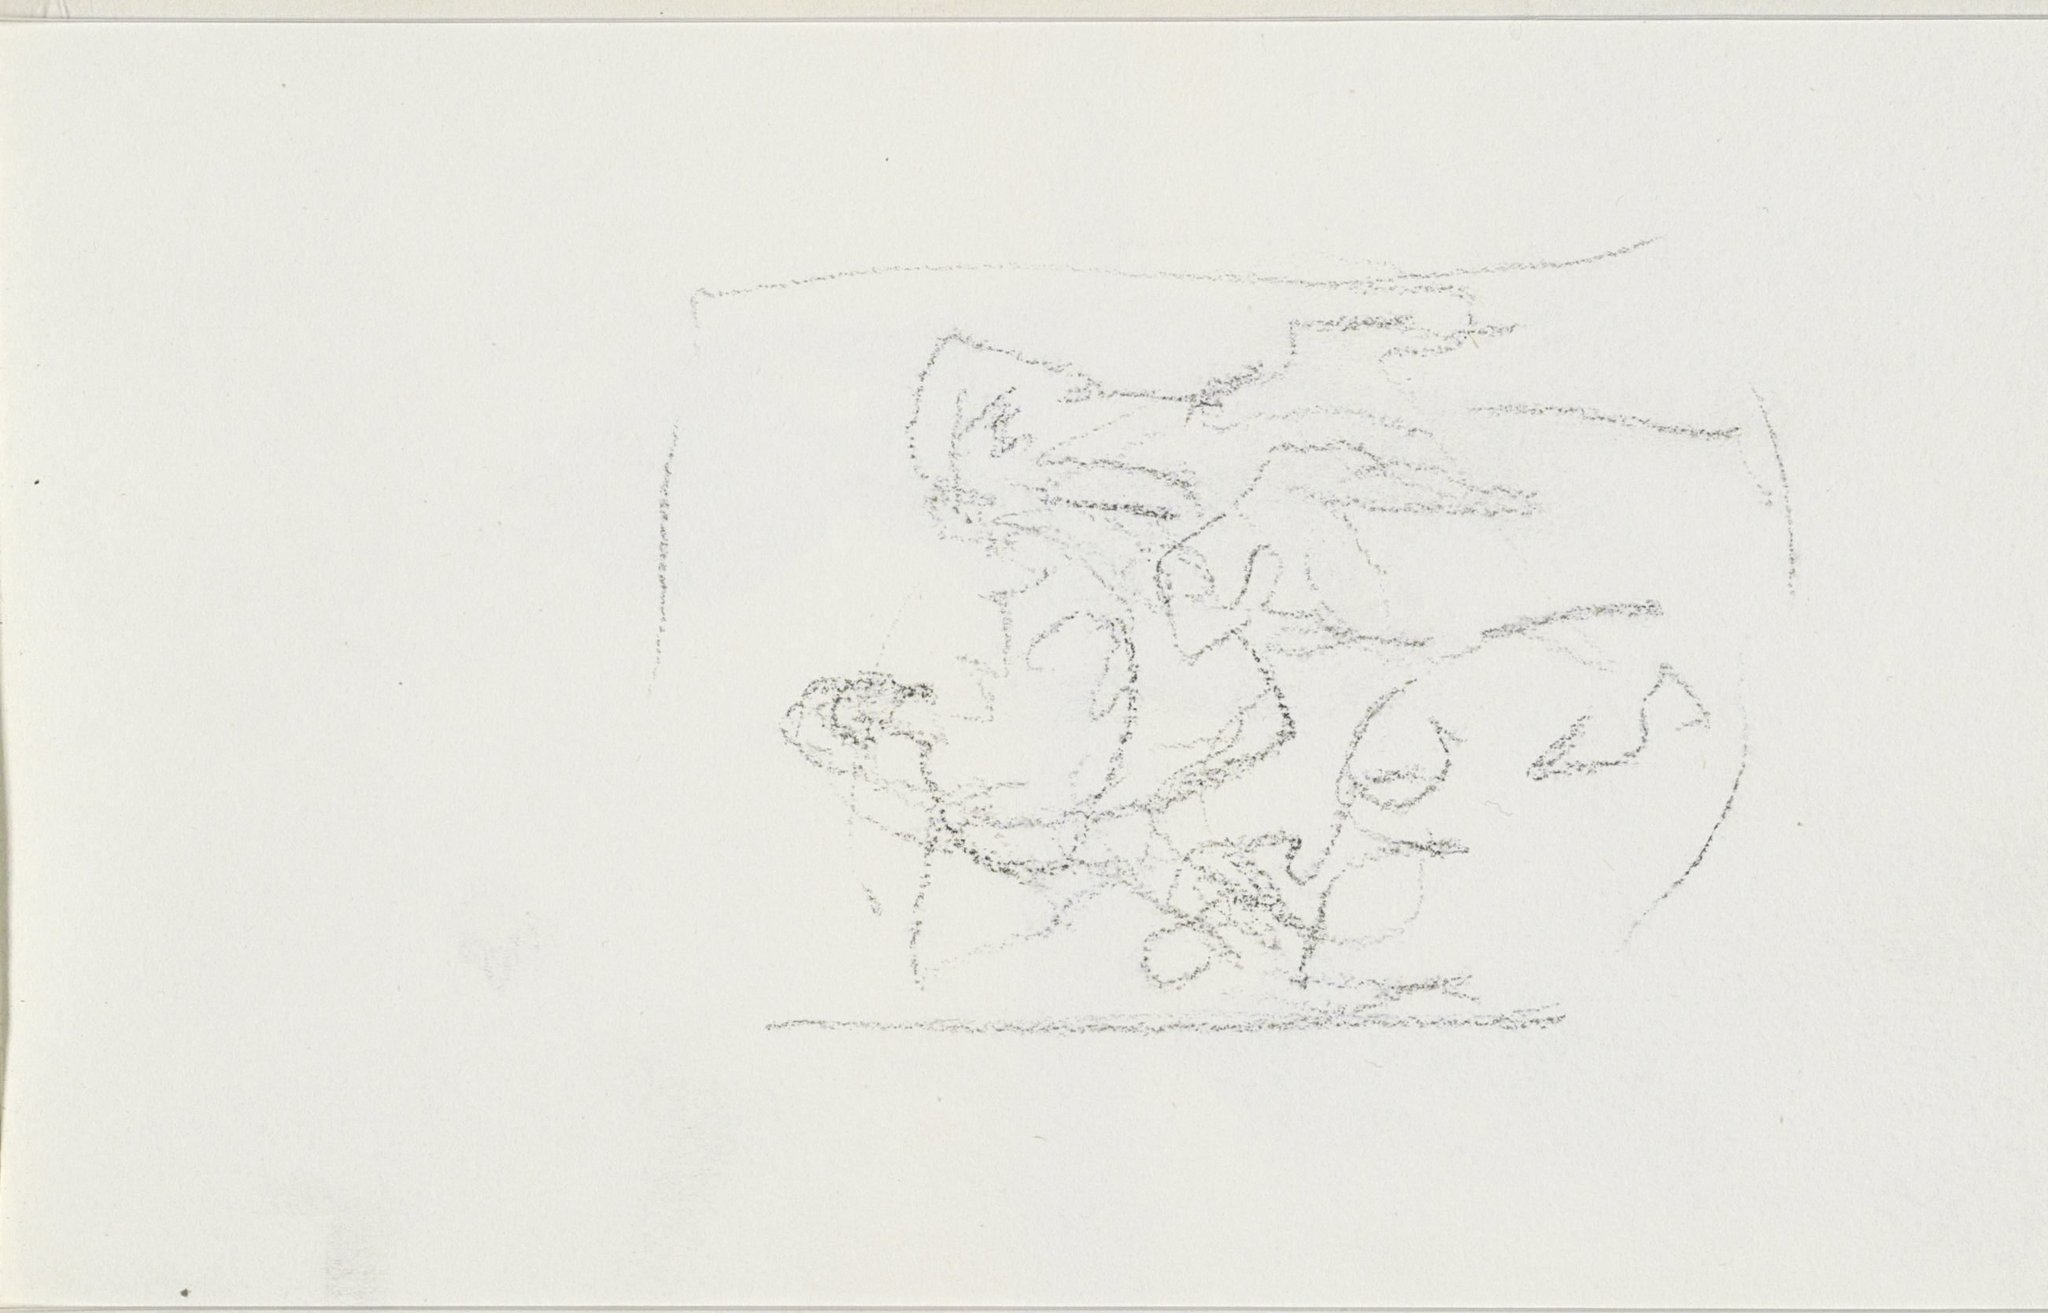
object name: sketchbook leaf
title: Egyptenaar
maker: marius bauer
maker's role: draughtsman, print maker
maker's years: 1867-1932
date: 1919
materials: chalk, paper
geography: egypt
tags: africans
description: Mogelijk zit de man op een kameel. Pagina 33 uit een schetsboek met 18 bladen.